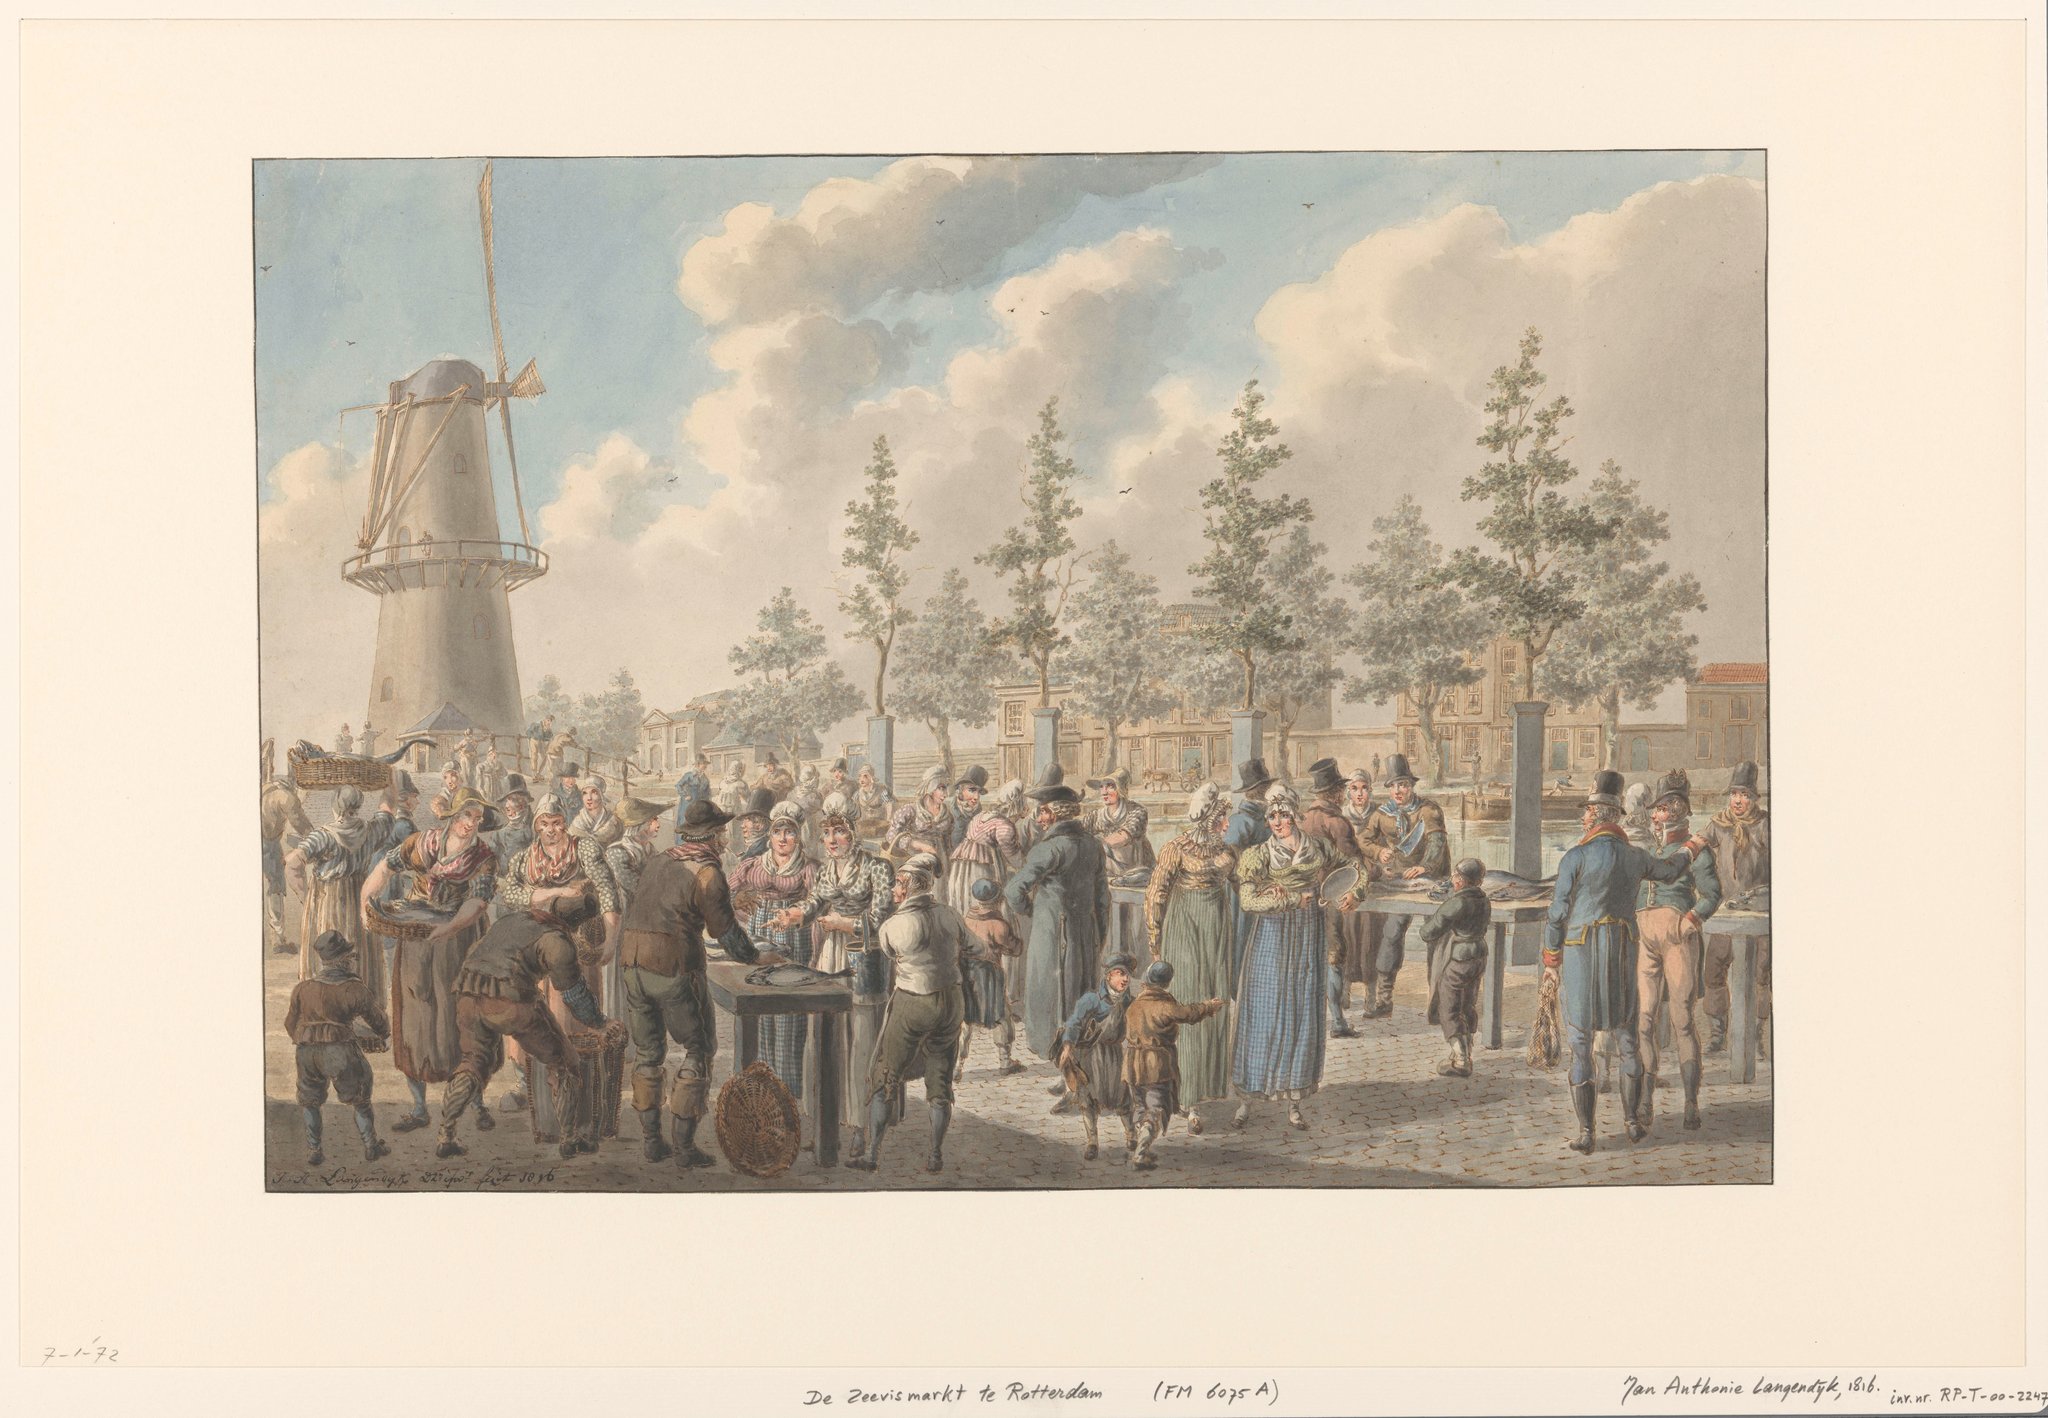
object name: watercolor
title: De vismarkt te Rotterdam, 1816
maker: jan anthonie langendijk dzn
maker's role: draughtsman, print maker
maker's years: 1780-1818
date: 1816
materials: ink, paper, watercolor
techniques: brush, pen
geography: netherlands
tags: fishes, market